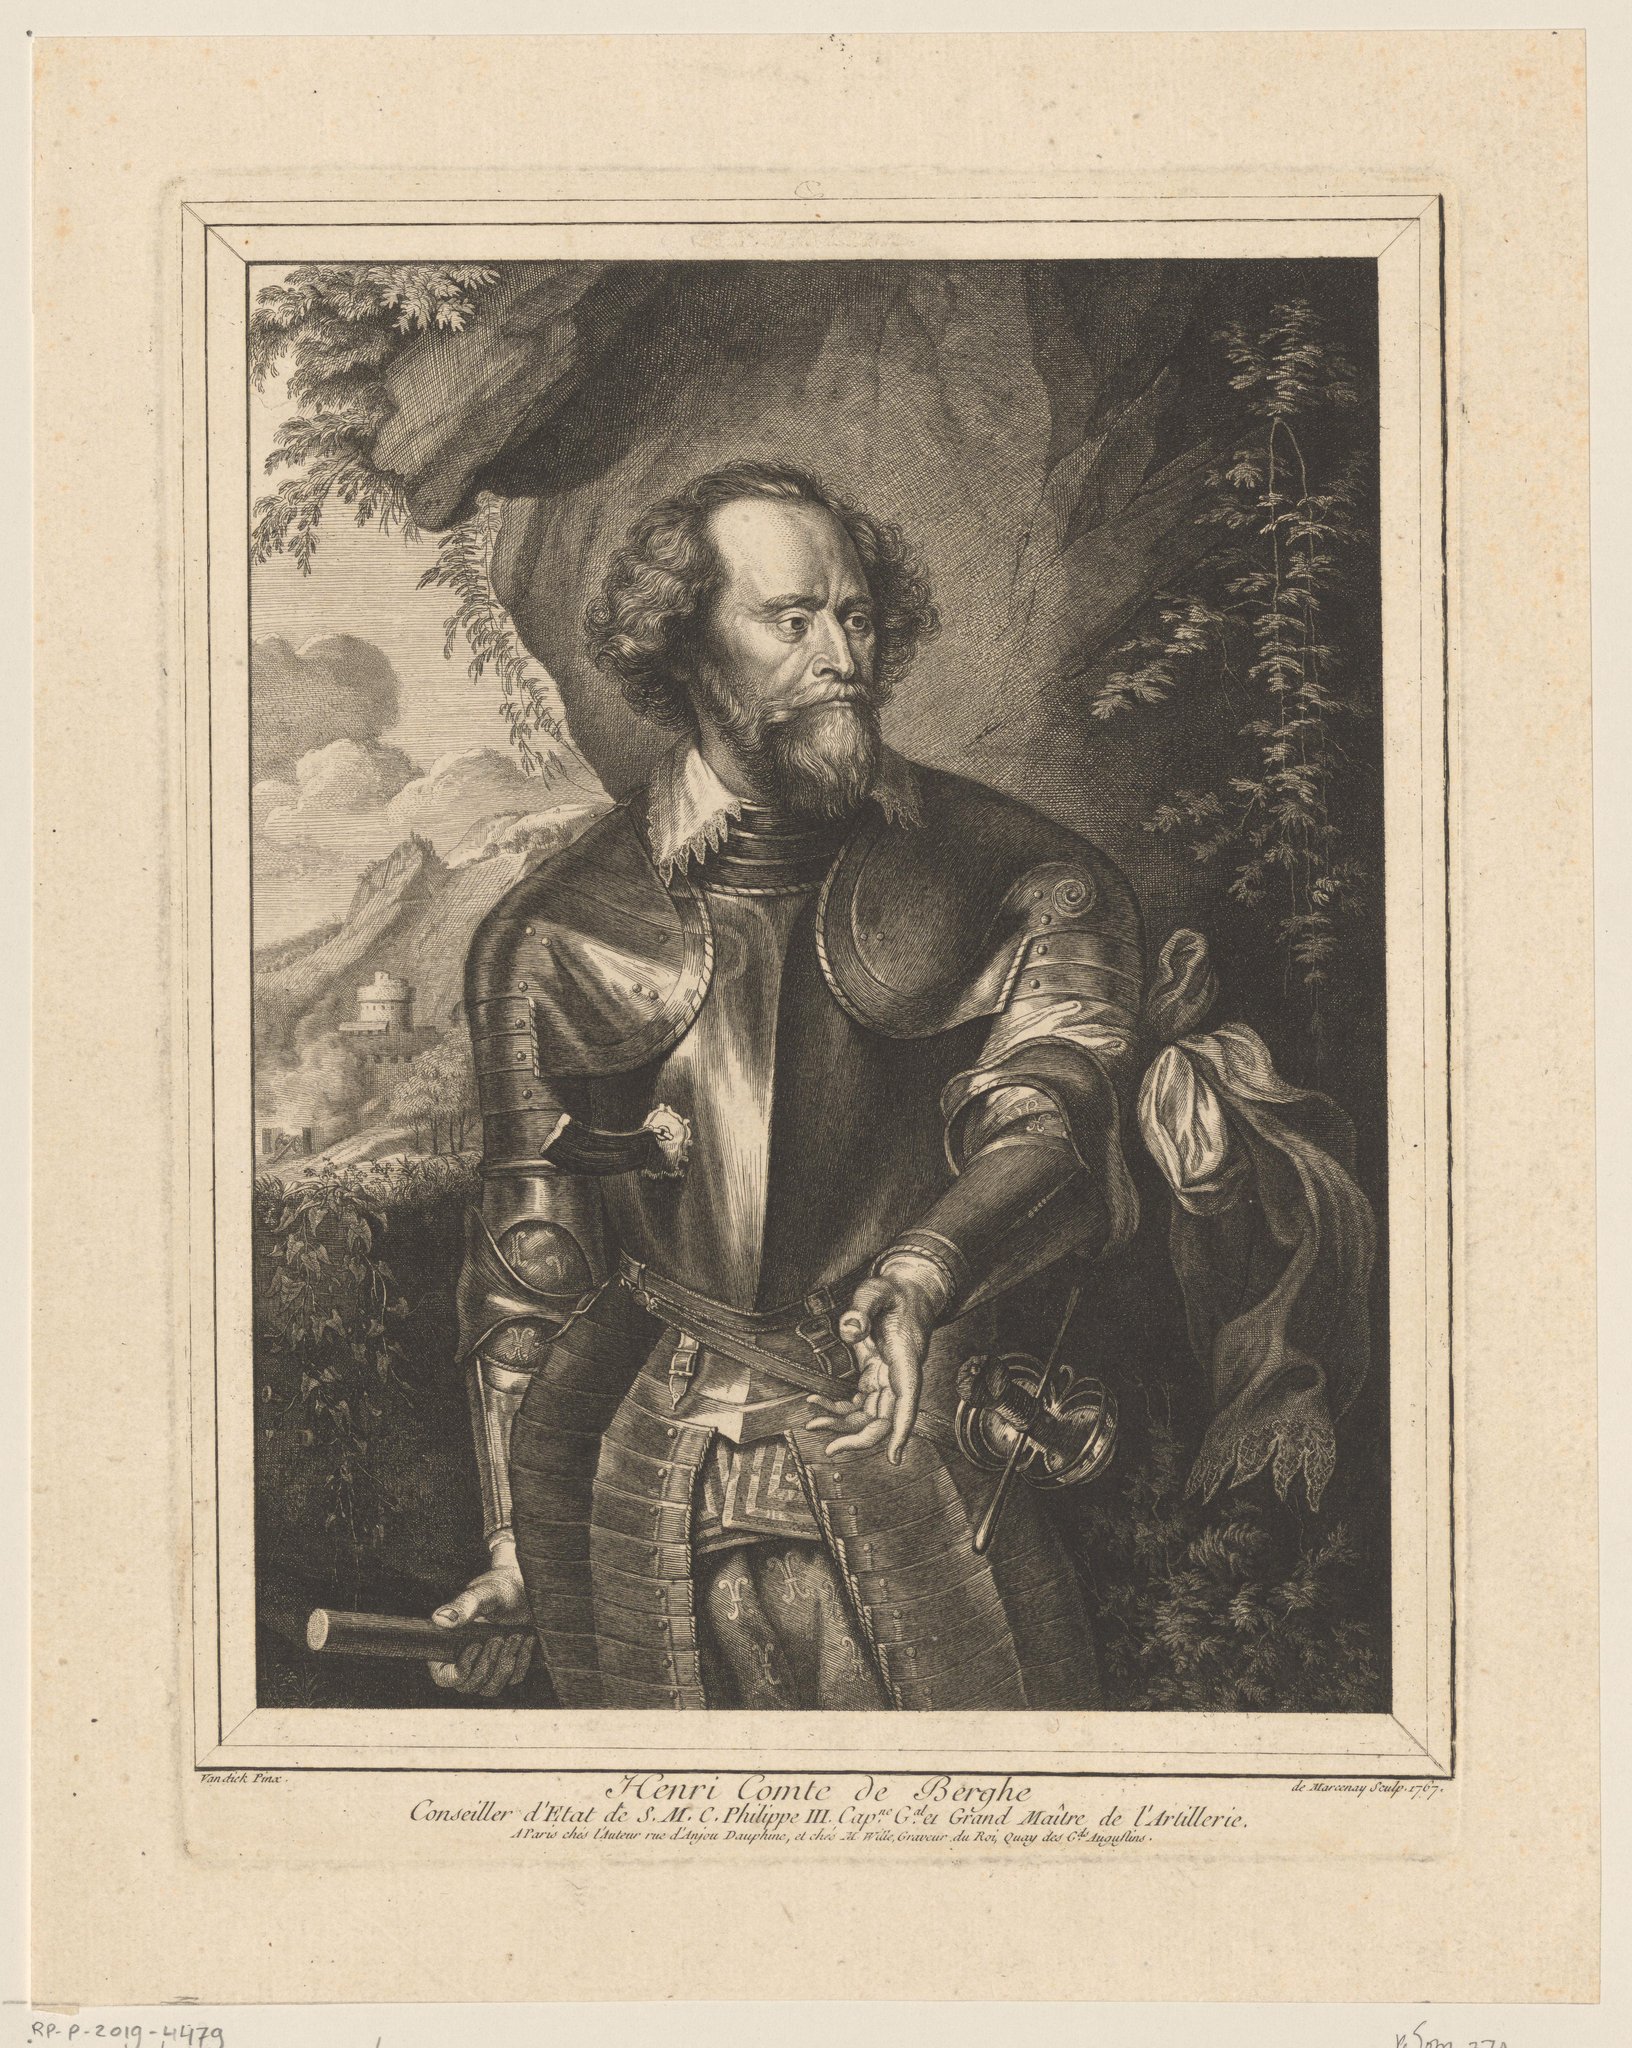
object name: print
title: Portret van Hendrik, graaf van den Bergh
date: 1767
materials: paper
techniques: engraving, etching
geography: paris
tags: earl, armour, historical persons, baton of general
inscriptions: collector's mark: Lugt 2228